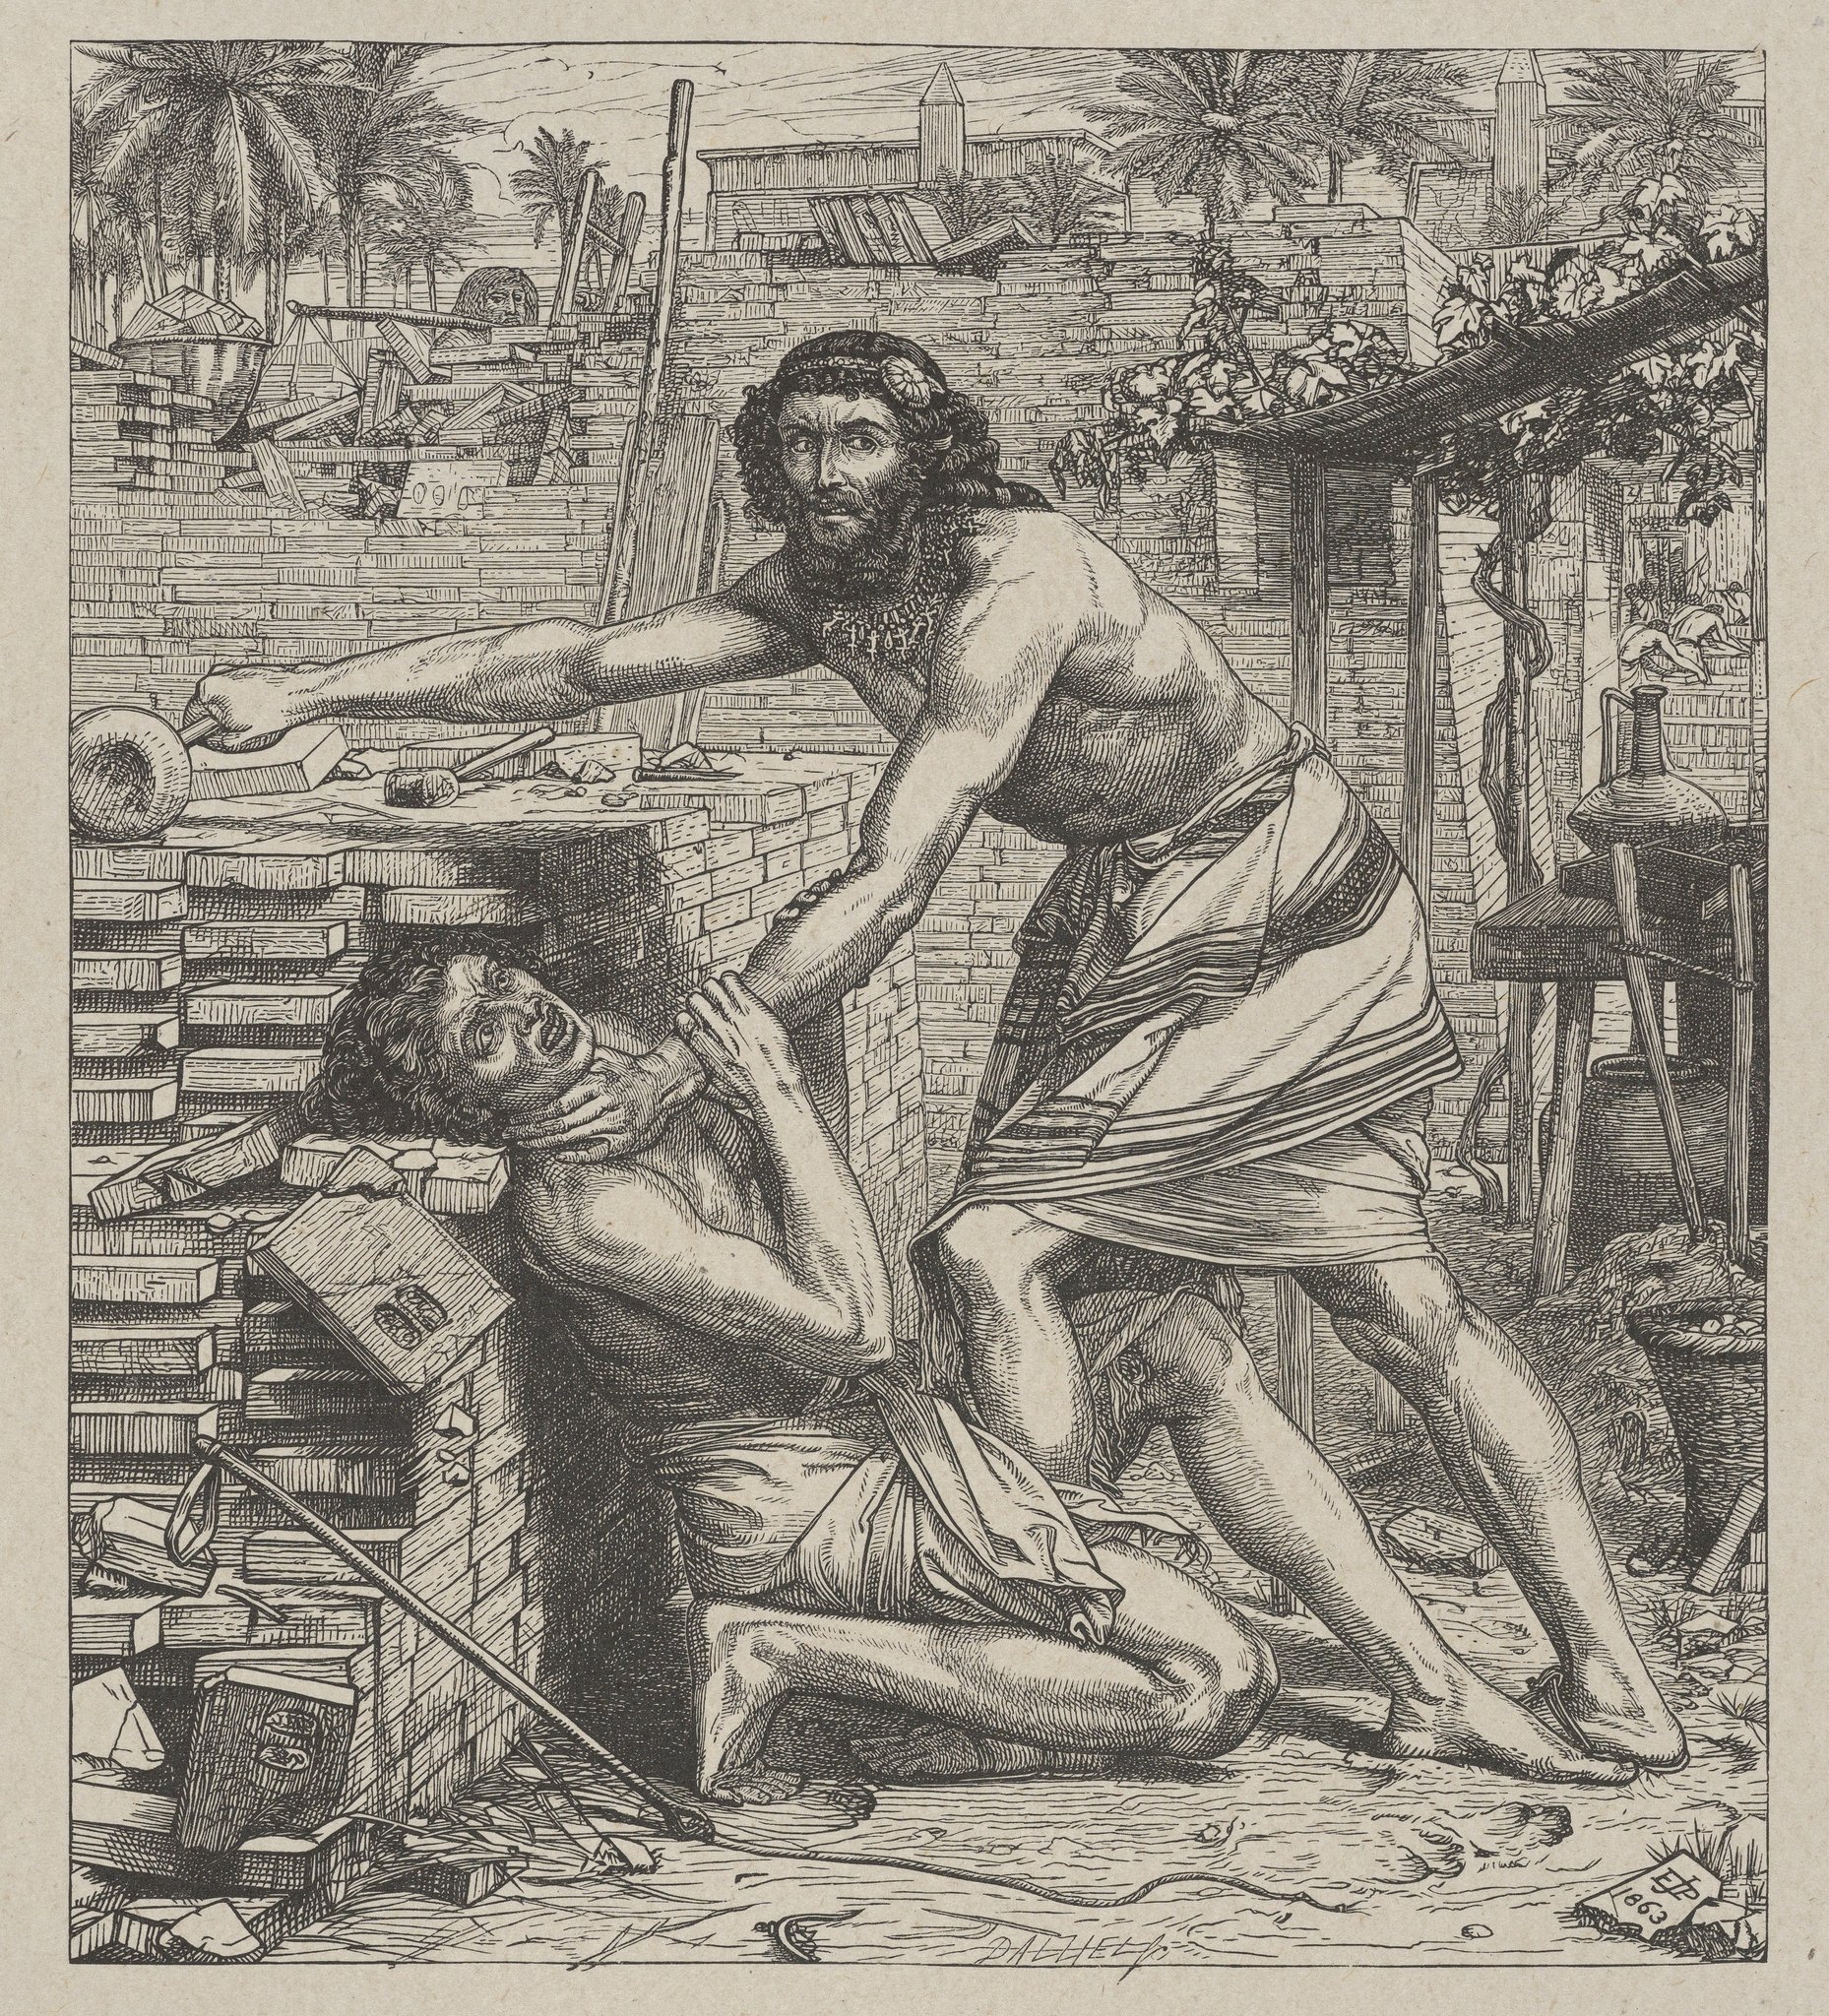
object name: print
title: Moses Slaying the Egyptian, from "Dalziels' Bible Gallery"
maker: sir edward john poynter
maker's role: artist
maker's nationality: british, born france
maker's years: 1836-1919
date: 1863-1881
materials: paper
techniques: engraving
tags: men,moses